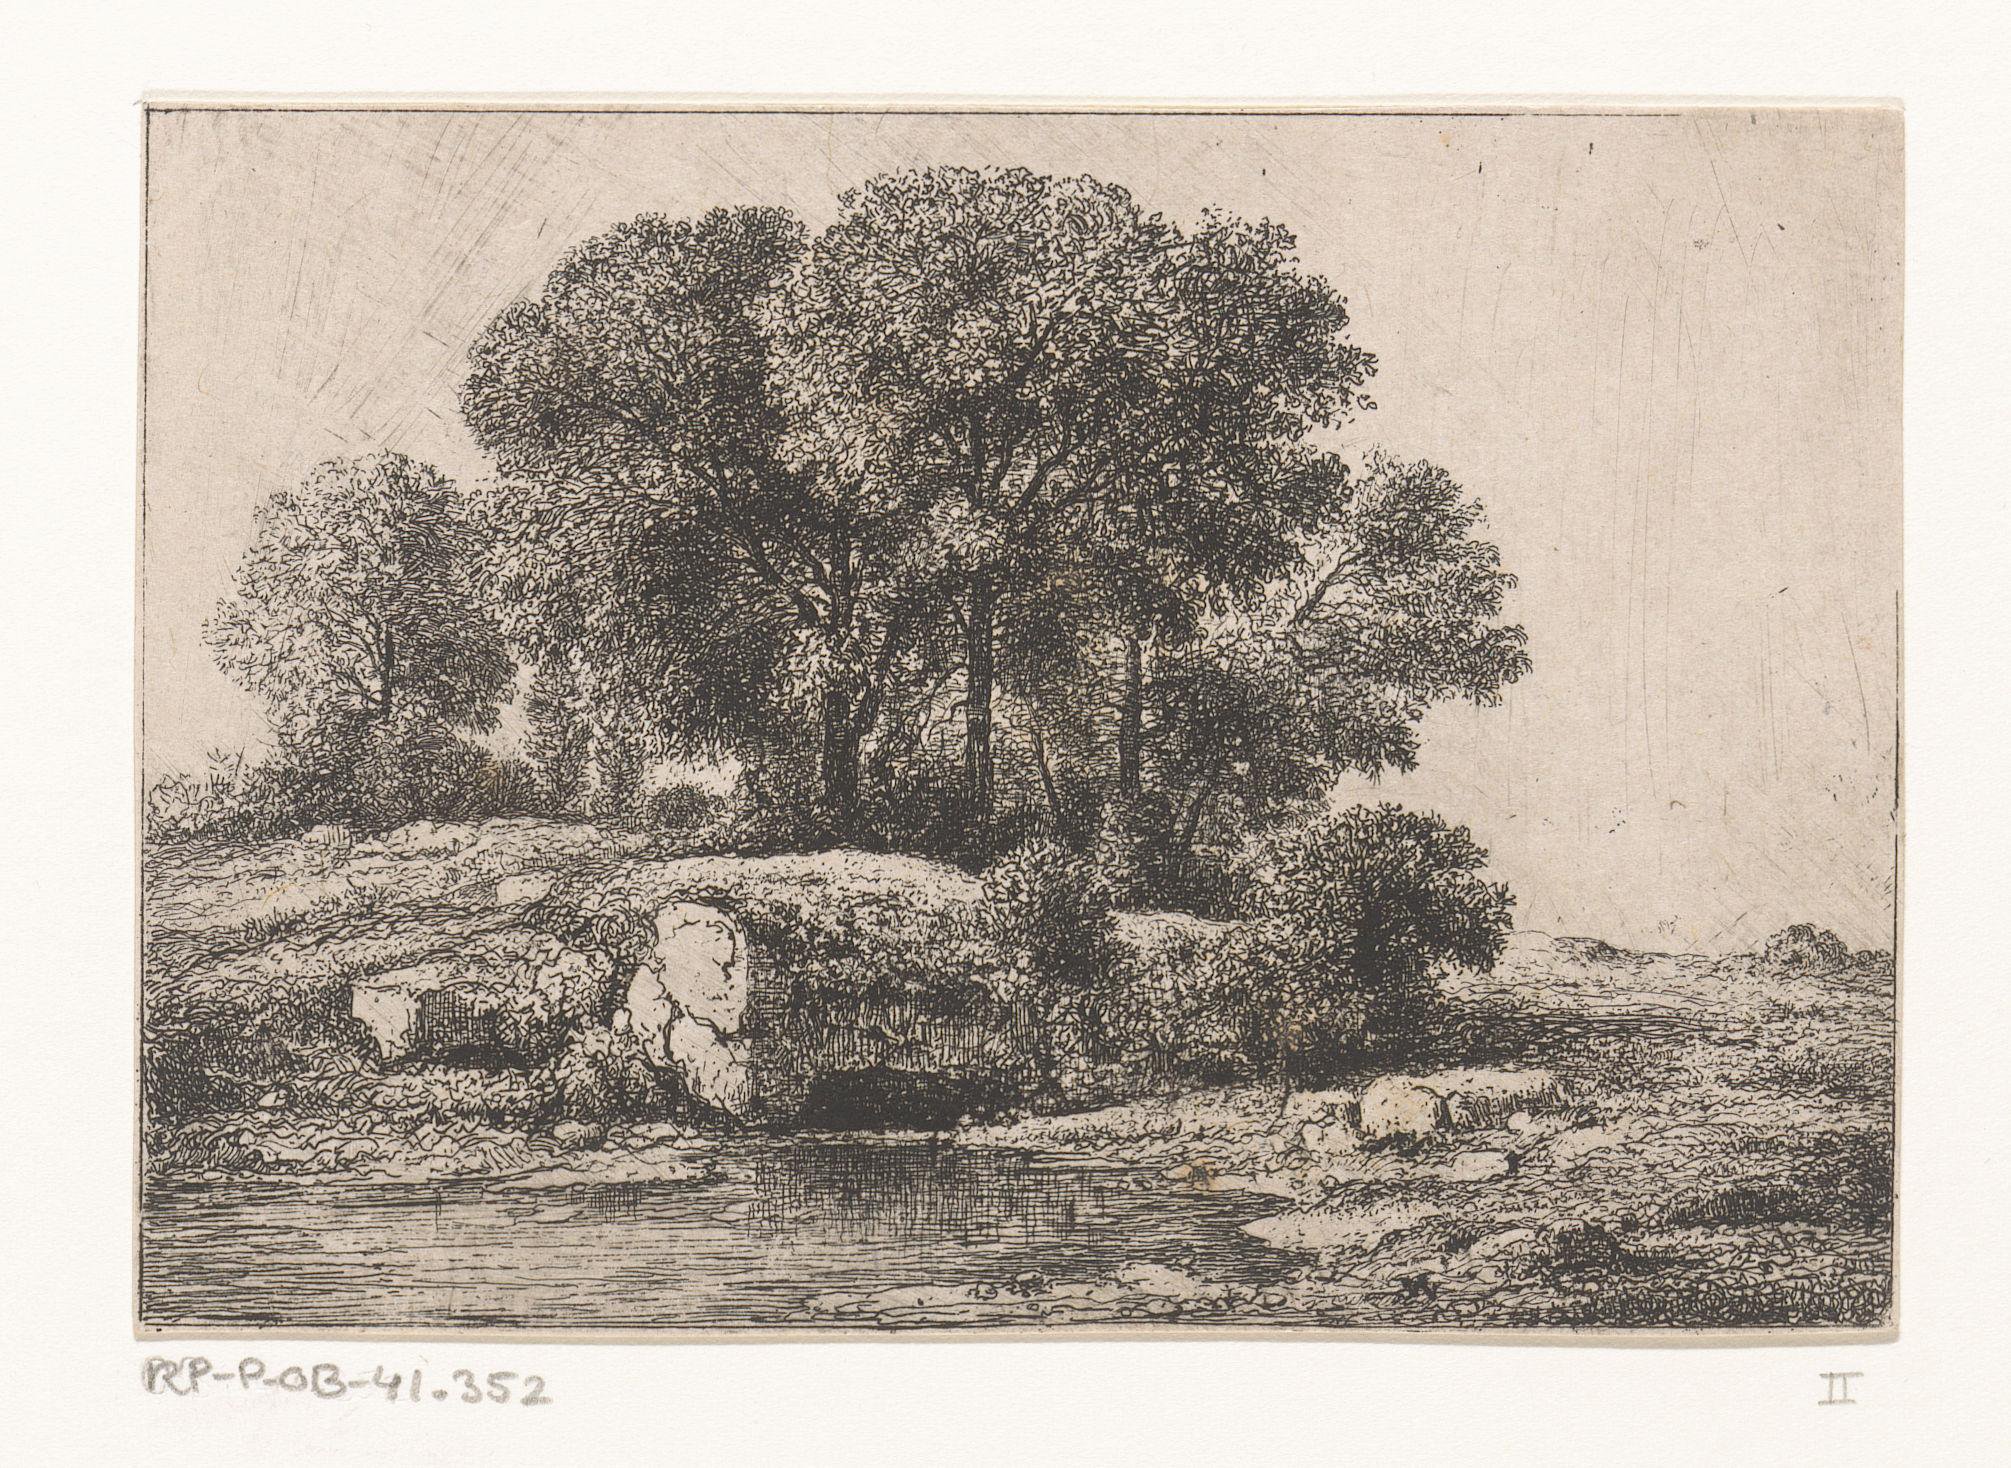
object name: print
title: Bomen bij een poel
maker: jean alexis achard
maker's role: print maker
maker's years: 1807-1884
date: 1817-1884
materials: paper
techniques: etching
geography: france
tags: trees, landscapes, pool, puddle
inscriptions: inscription: ‘1er état / avant la ciel / Épreuve d'essai avant la ciel et a[...] / unique [?]’, collector's mark: Lugt 2228